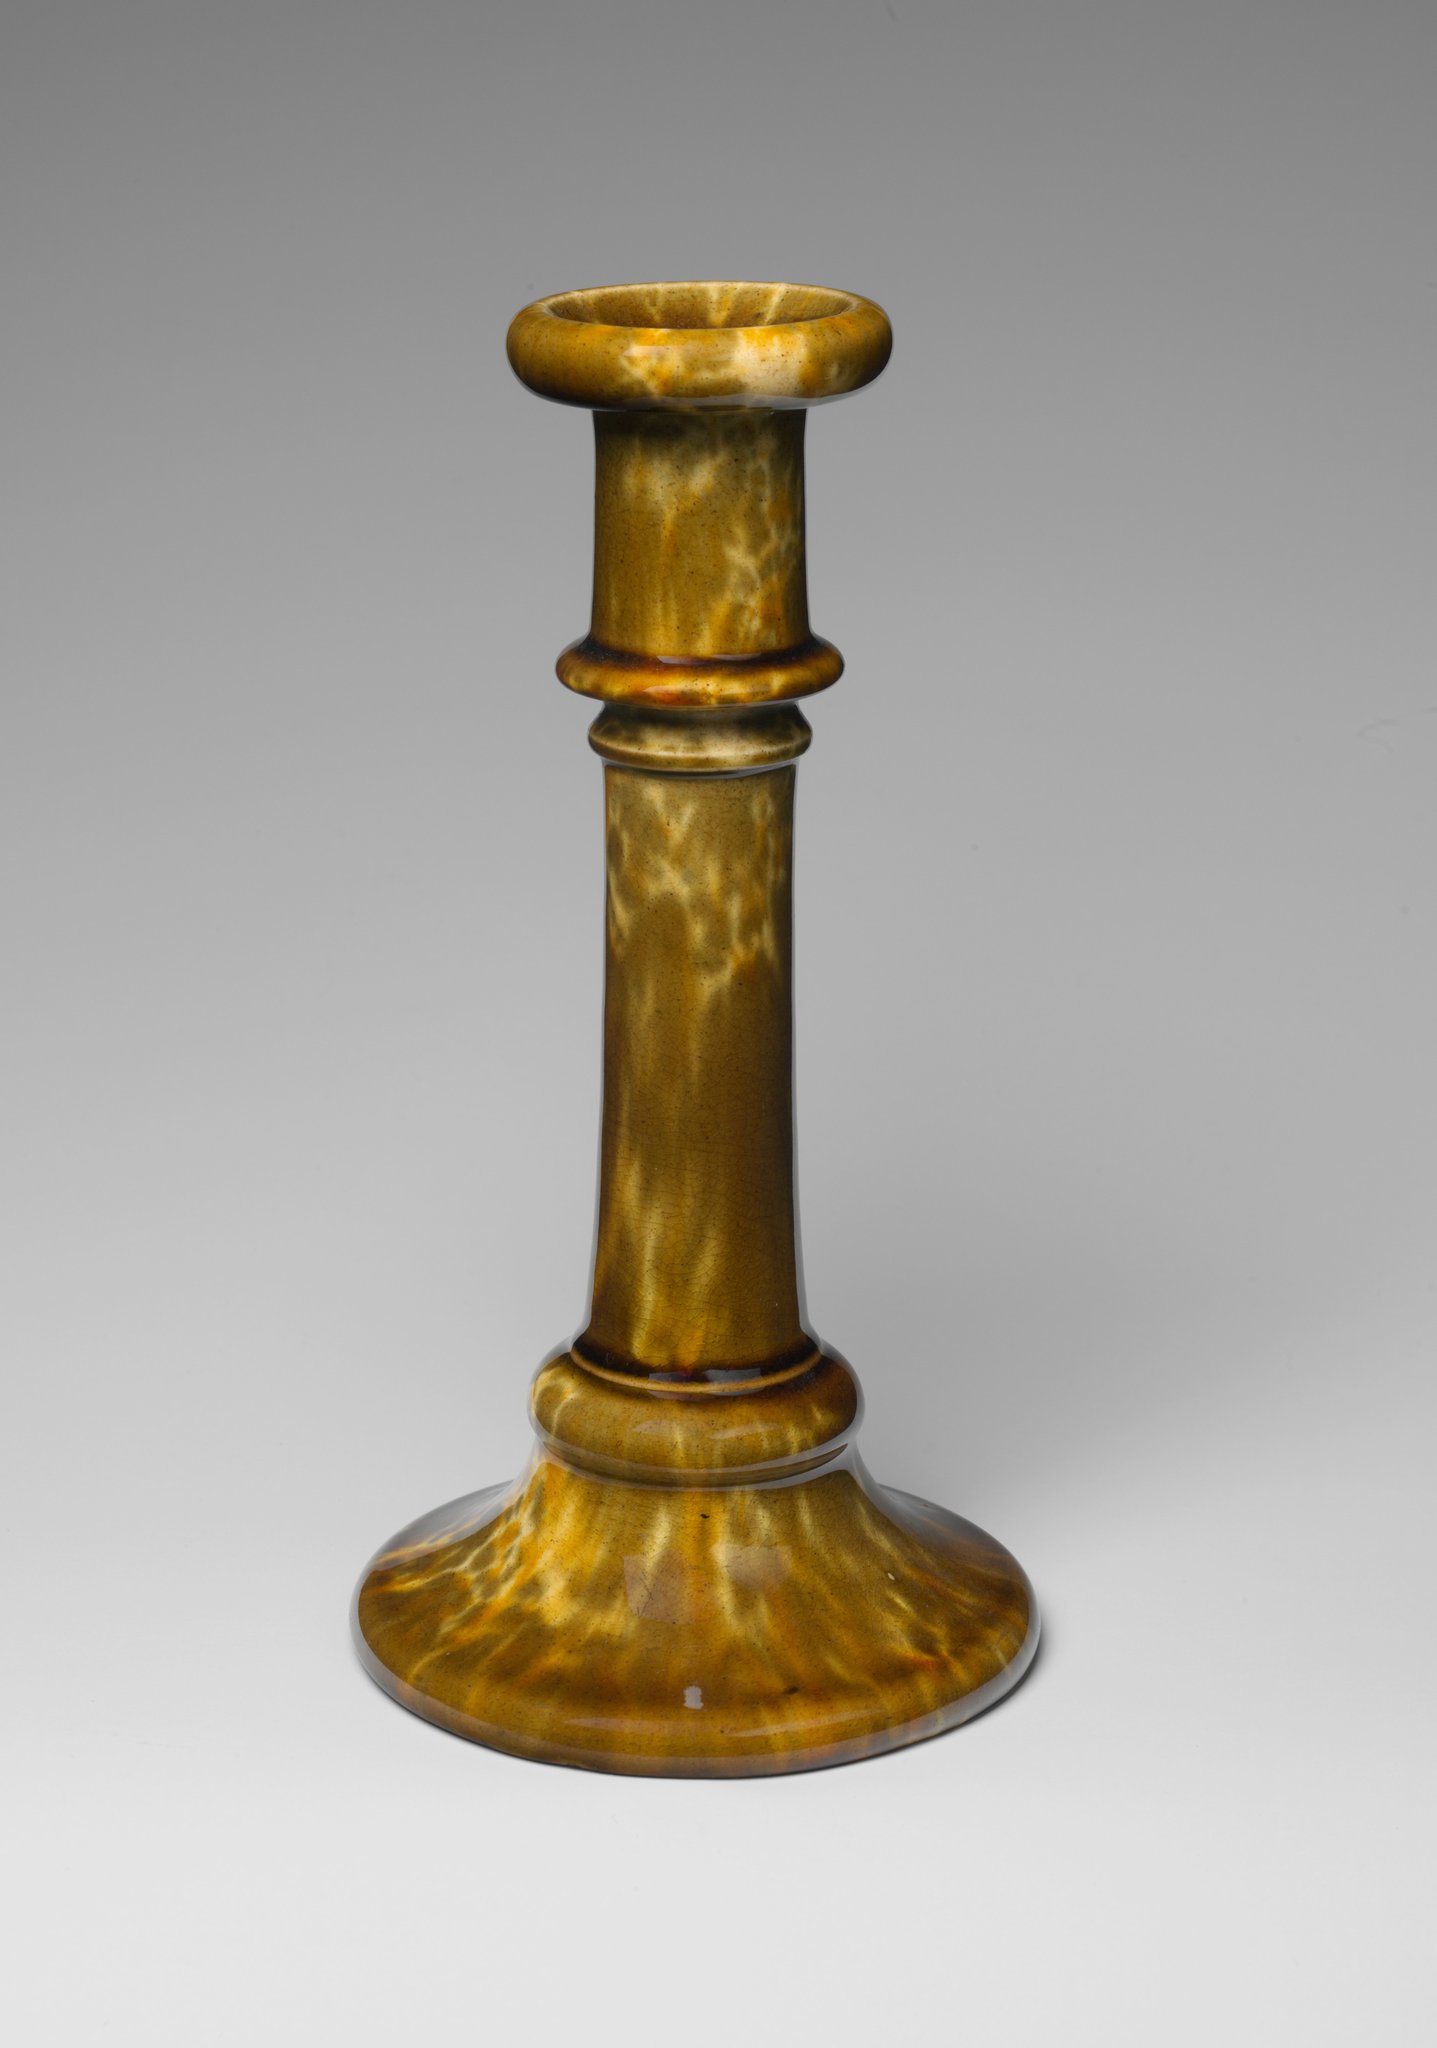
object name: candlestick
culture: american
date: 1830-1870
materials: earthenware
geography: united states